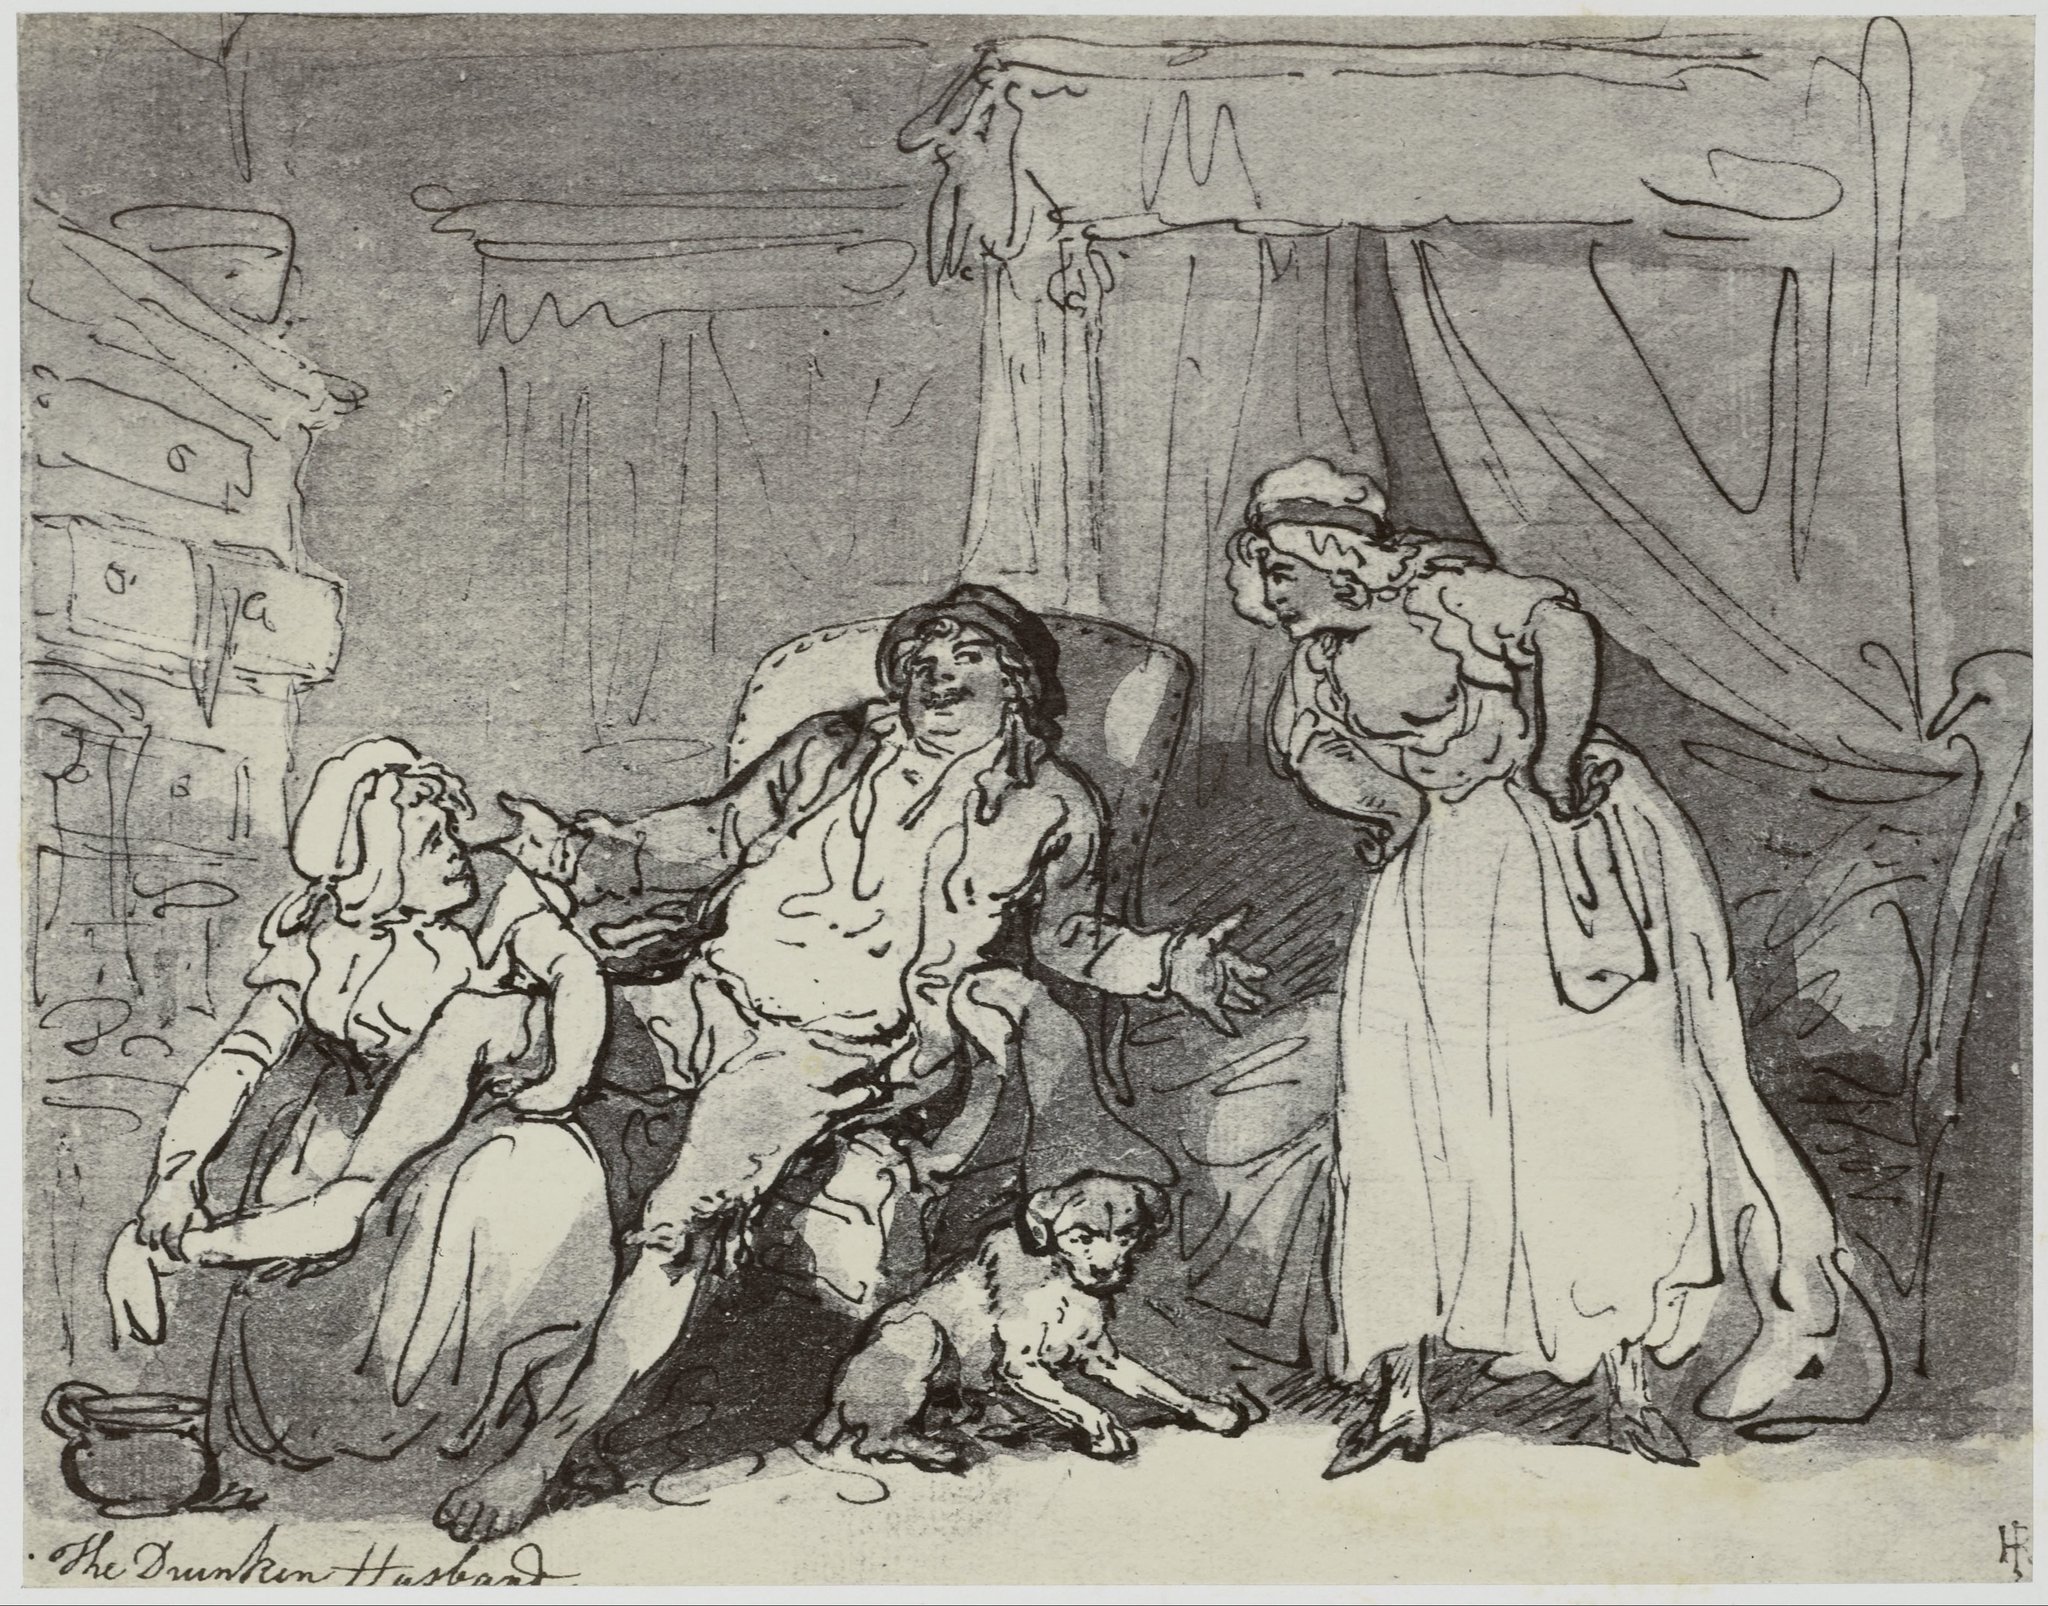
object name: photograph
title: Thomas Rowlandson, The Drunken Husband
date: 1855-1858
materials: cardboard, paper, photographic support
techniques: albumen print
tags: london, print maker, thomas rowlandson, drawing, sketch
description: Fotoreproductie van tekening in 'The Reveley Collection of Drawings at Brynygwin', afb. 55.